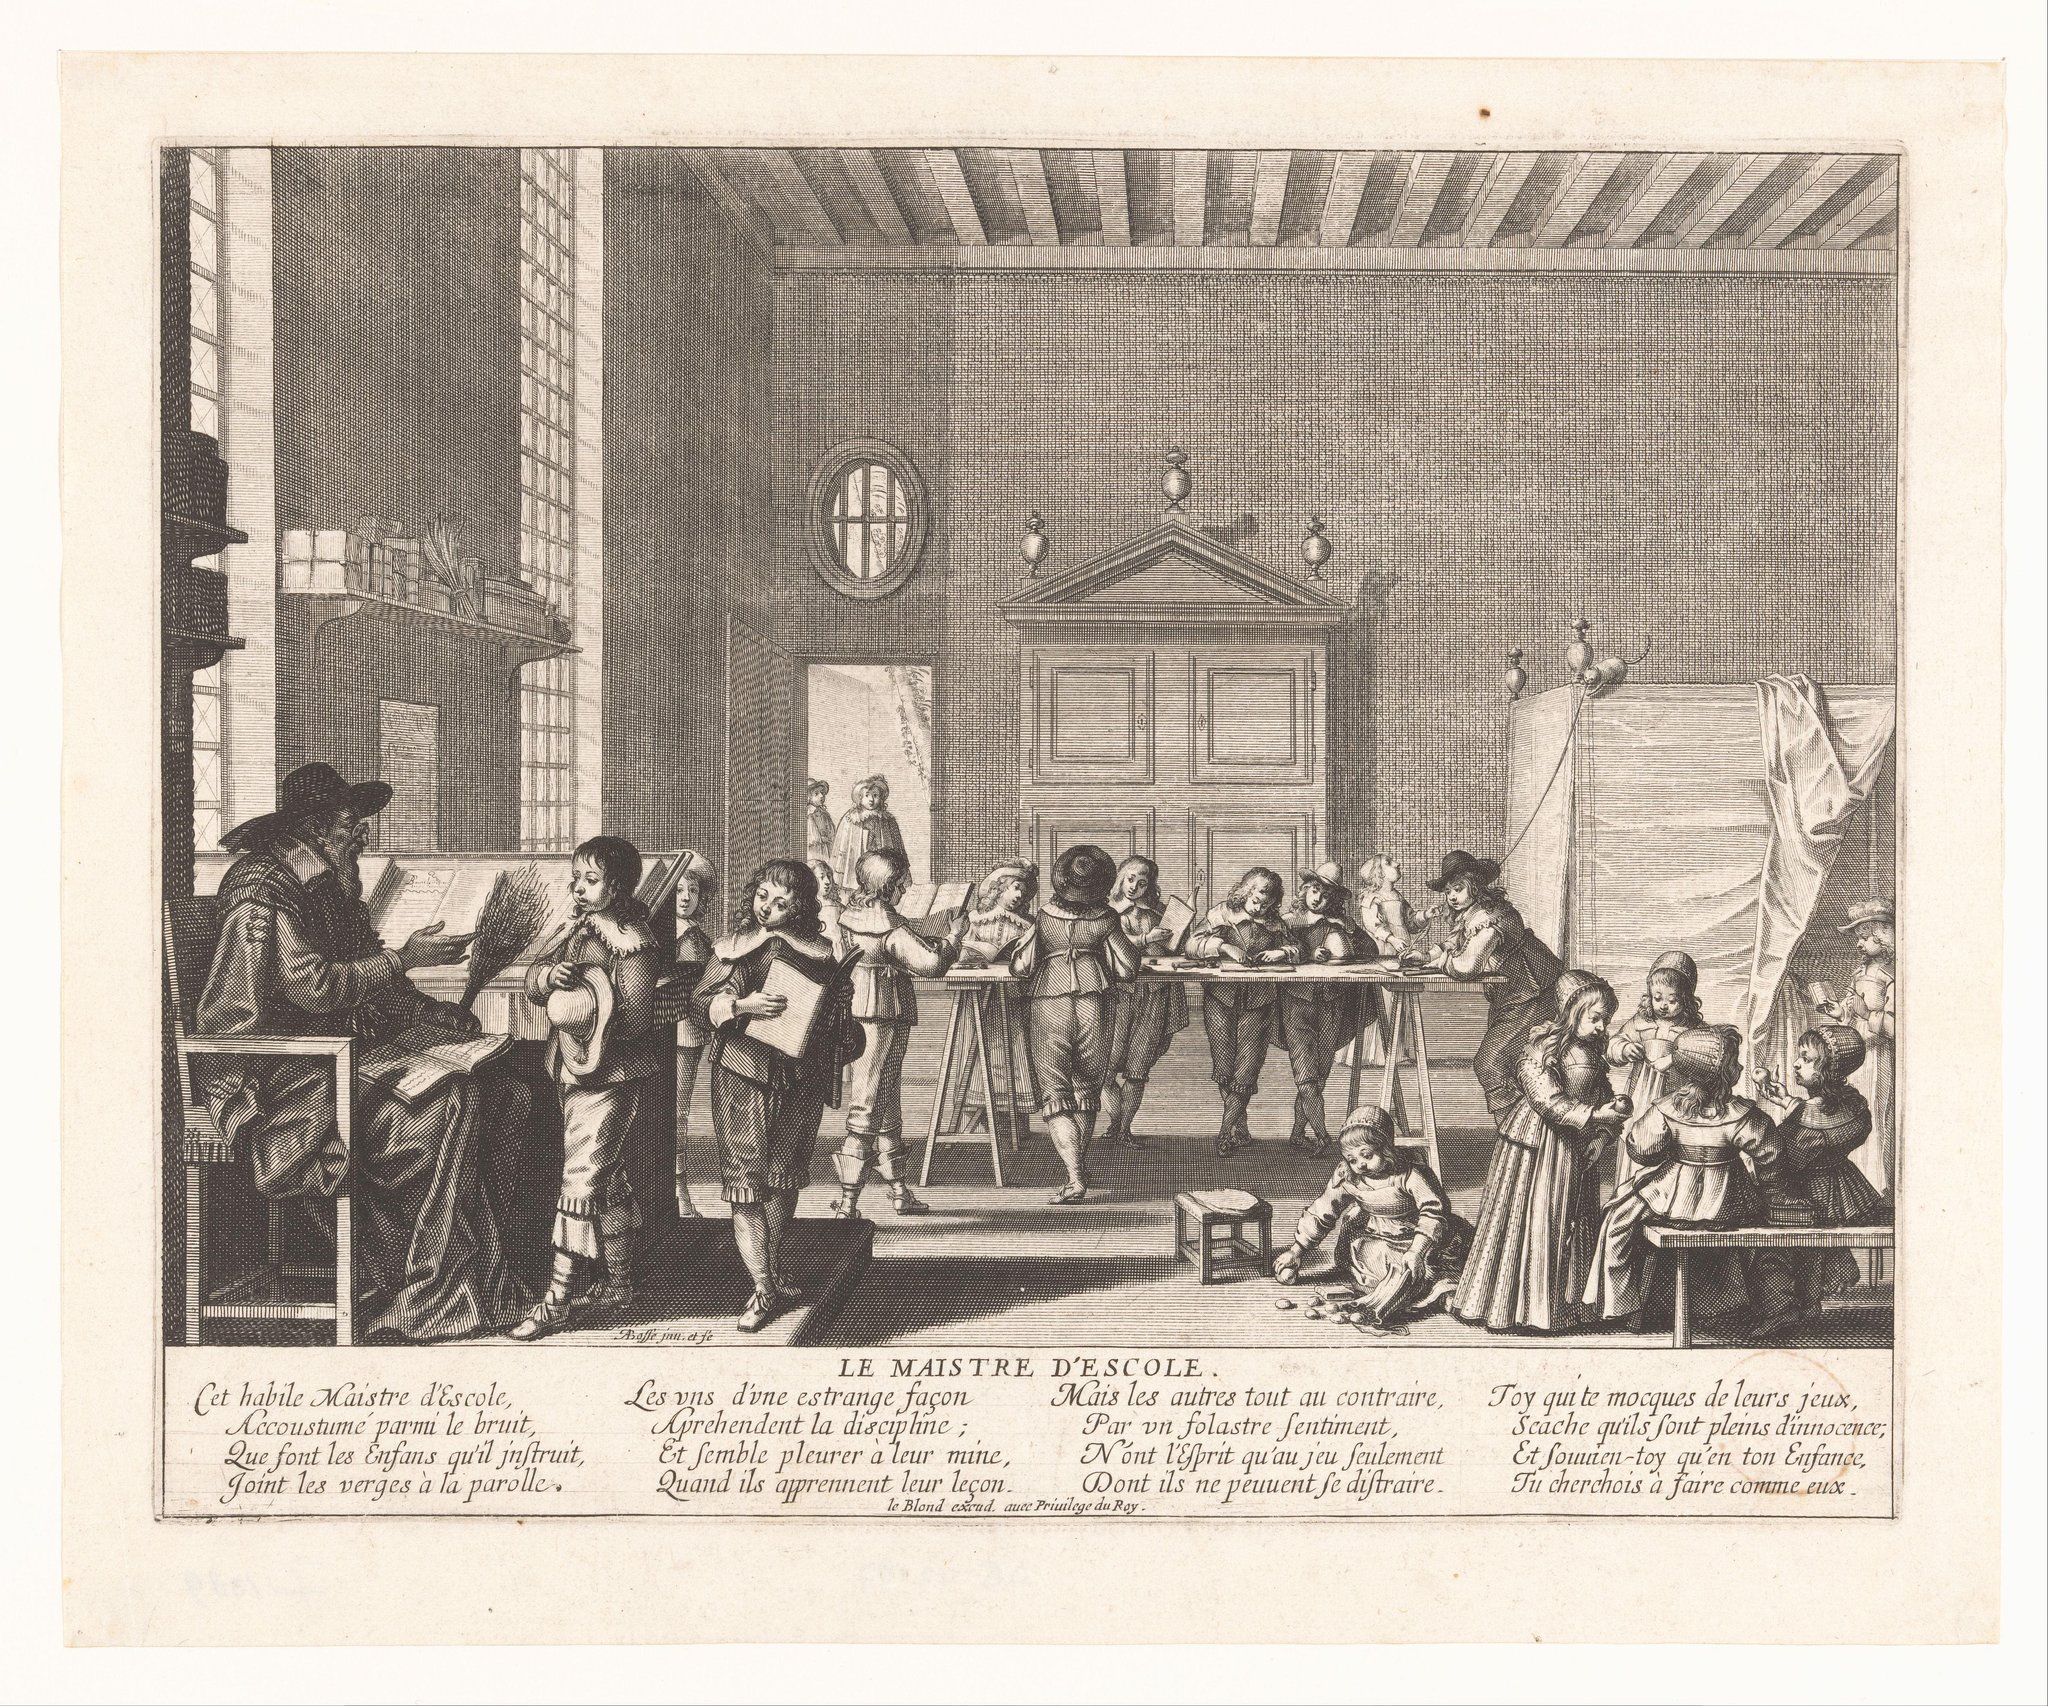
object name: print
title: Schoolmeester in een klaslokaal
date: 1638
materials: paper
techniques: engraving, etching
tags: teacher and pupil, scholastic education, tuition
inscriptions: collector's mark: Lugt 240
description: Maakt deel uit van een serie van zeven prenten met beroepen.